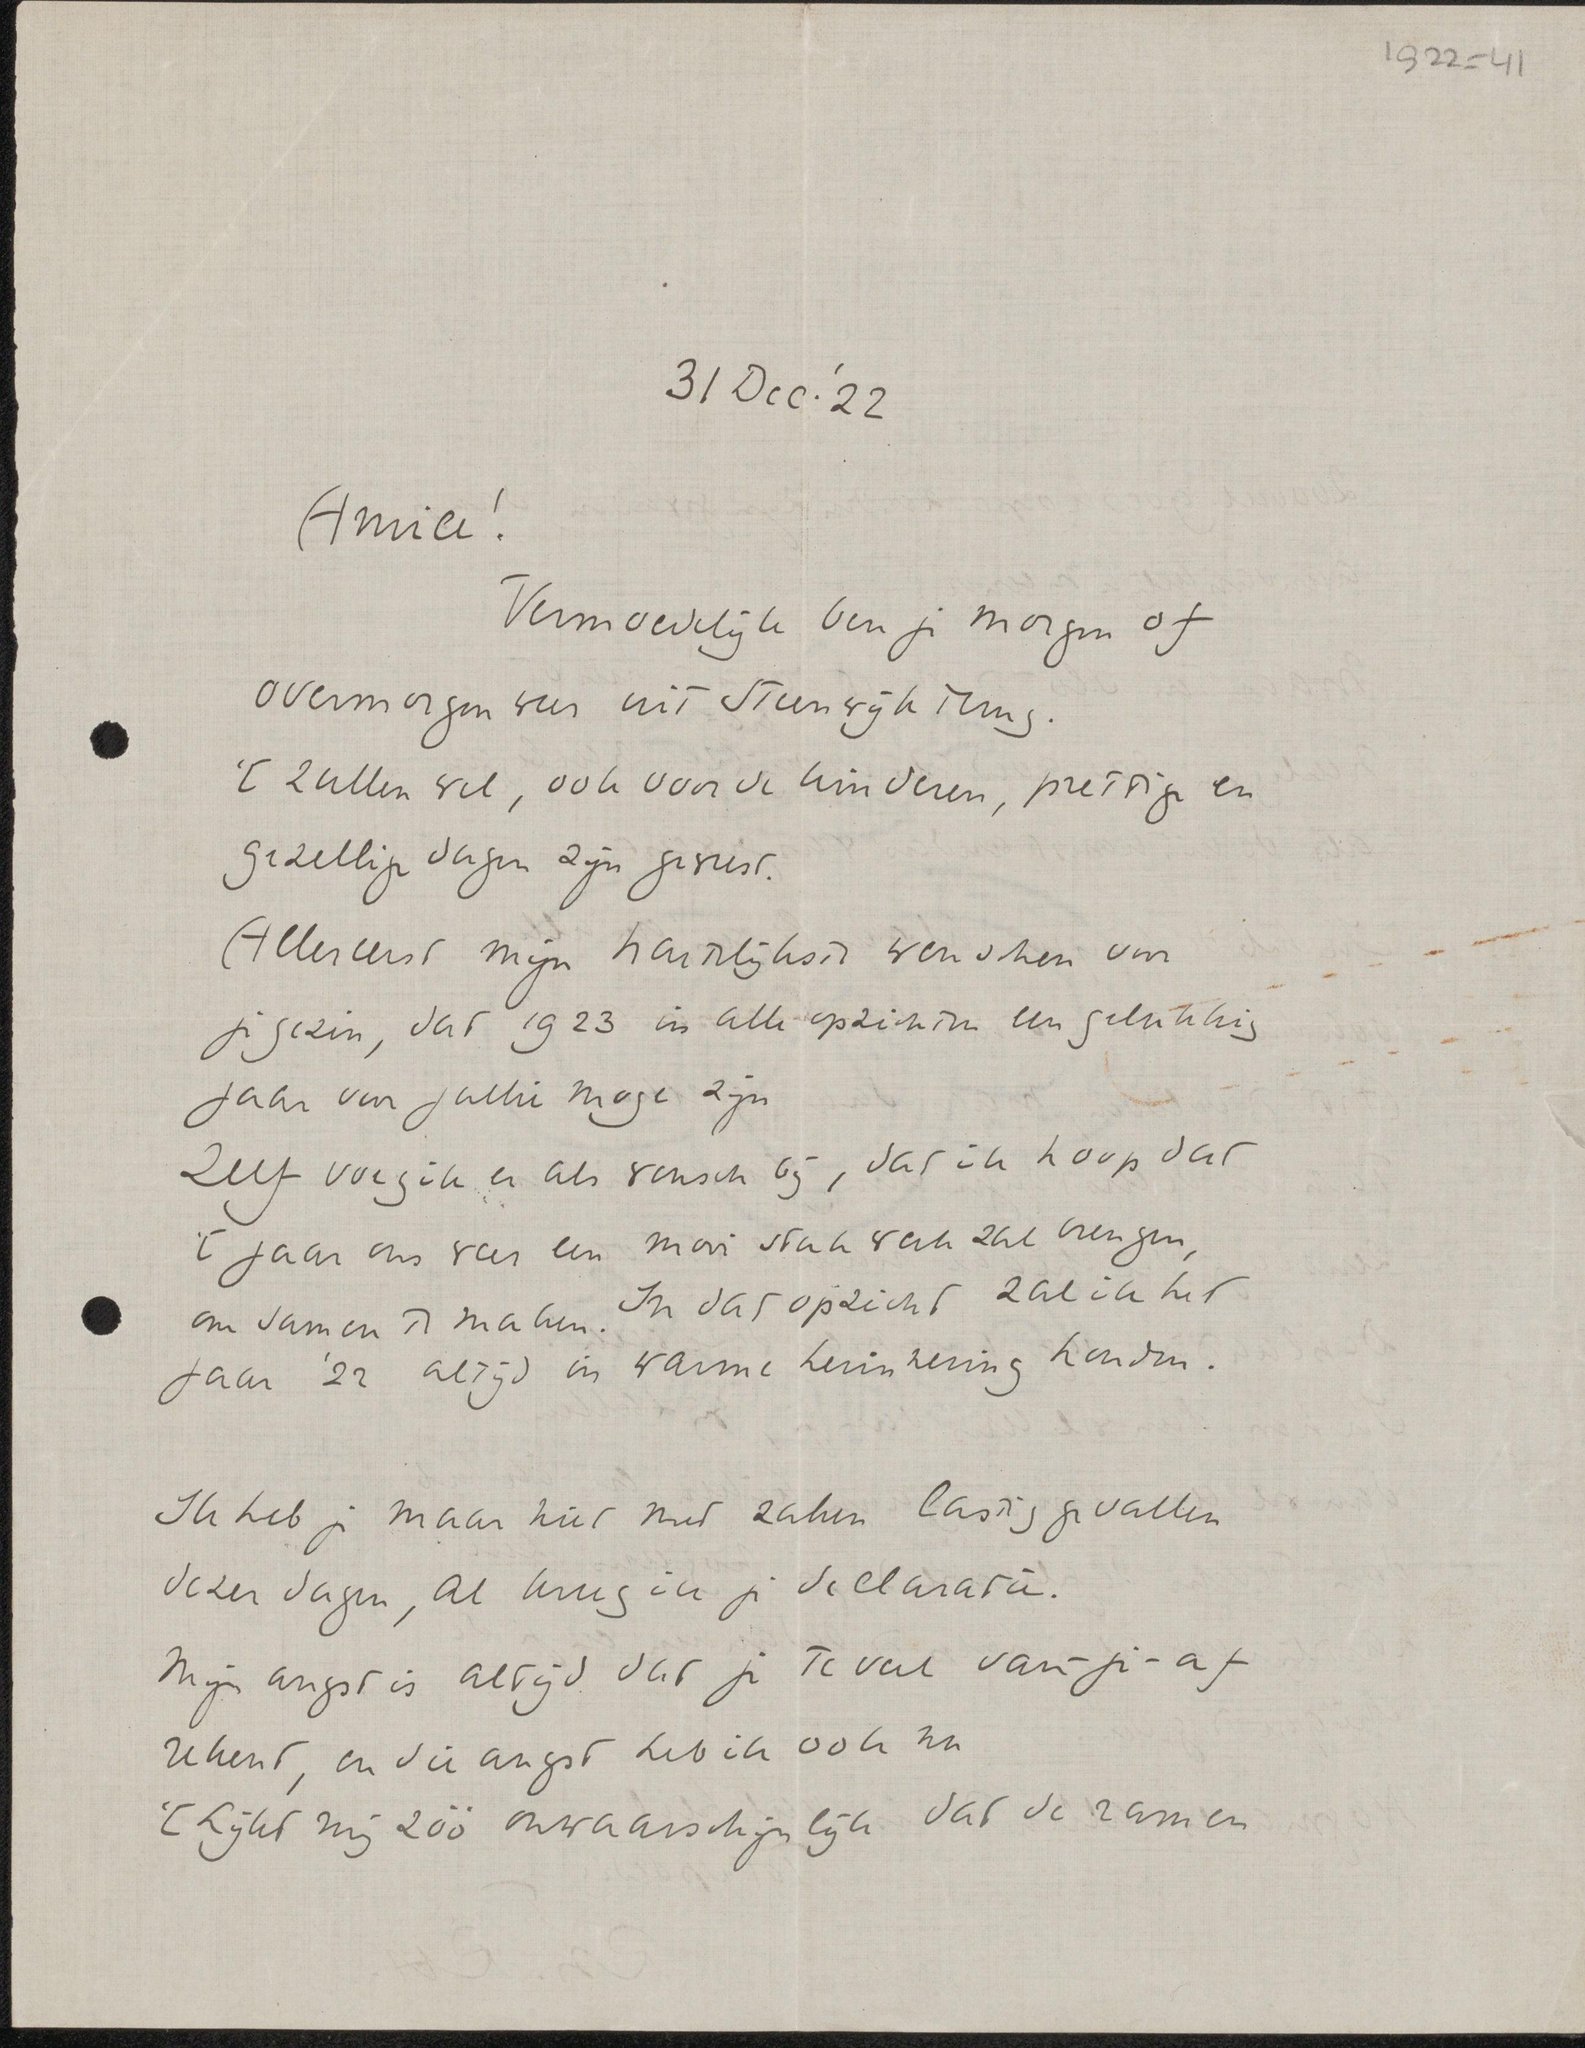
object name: letter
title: Brief aan Willem Bogtman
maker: richard nicolaüs roland holst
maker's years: 1868-1938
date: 1922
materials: ink, paper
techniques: pen, writing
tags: haarlem, willem bogtman, applied arts, arts and crafts; industrial design, exhibition ~ art, money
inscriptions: watermark